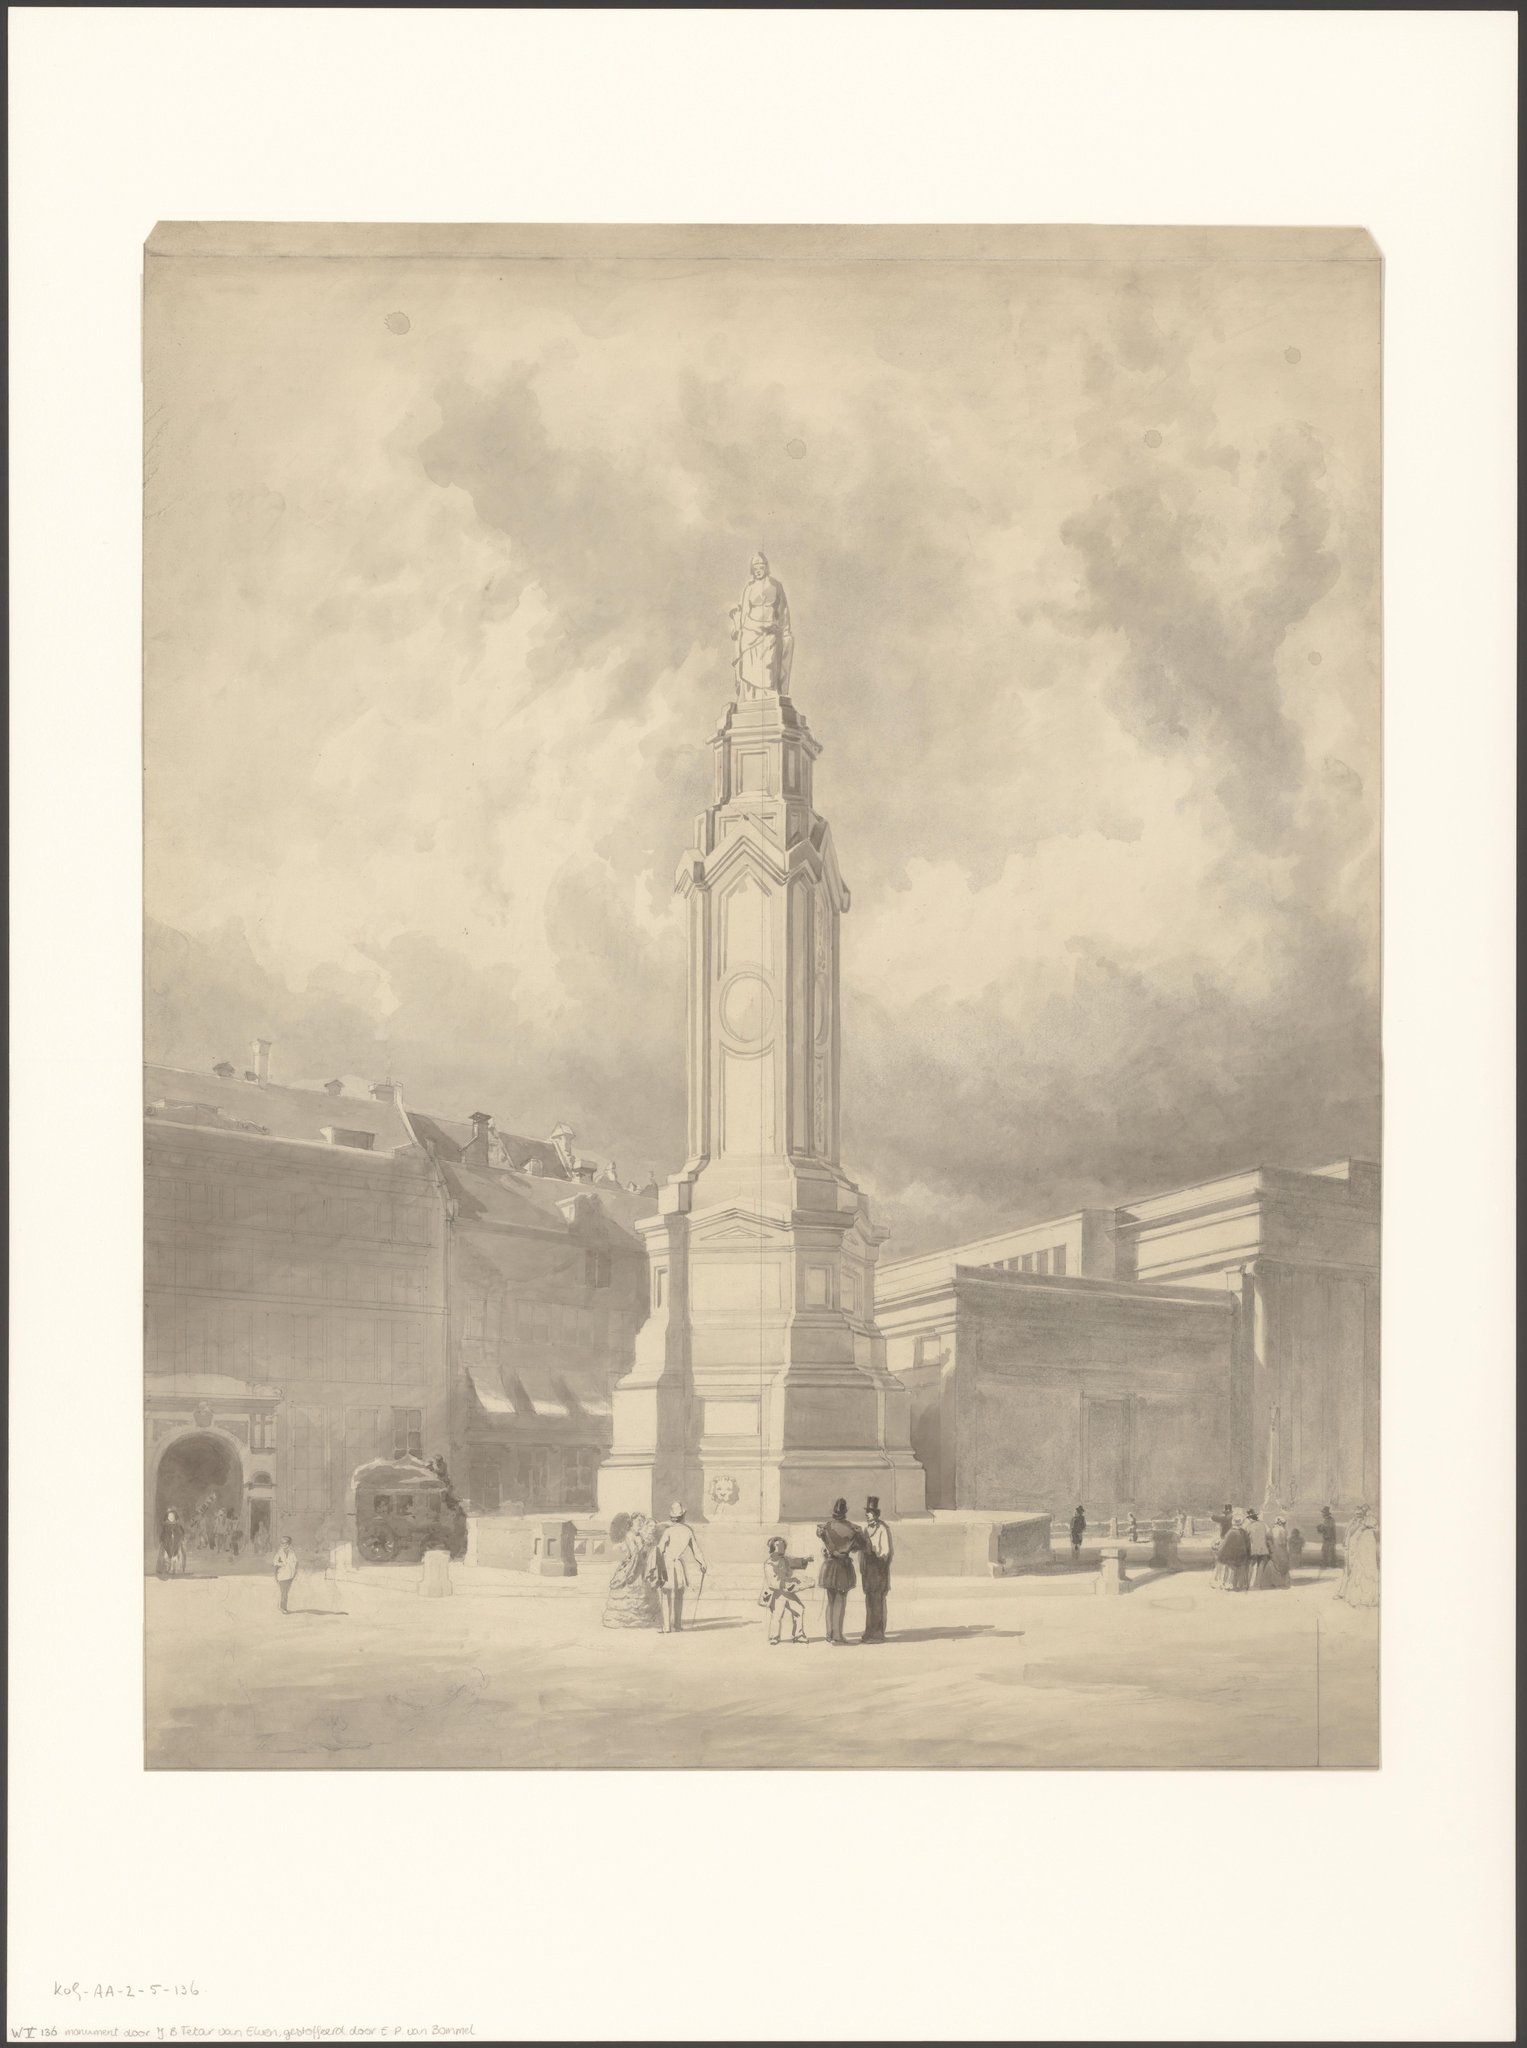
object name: drawing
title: Ontwerp voor een monument voor Johannes Baptist Tetar van Elven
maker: Anonymous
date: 1889-1950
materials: ink, paper, pencil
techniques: brush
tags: city-view in general; 'veduta', monument, statue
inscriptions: collector's mark: Lugt 800a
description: Tekening binnen de Atlas Van Eck ingedeeld op wijknummer 5.